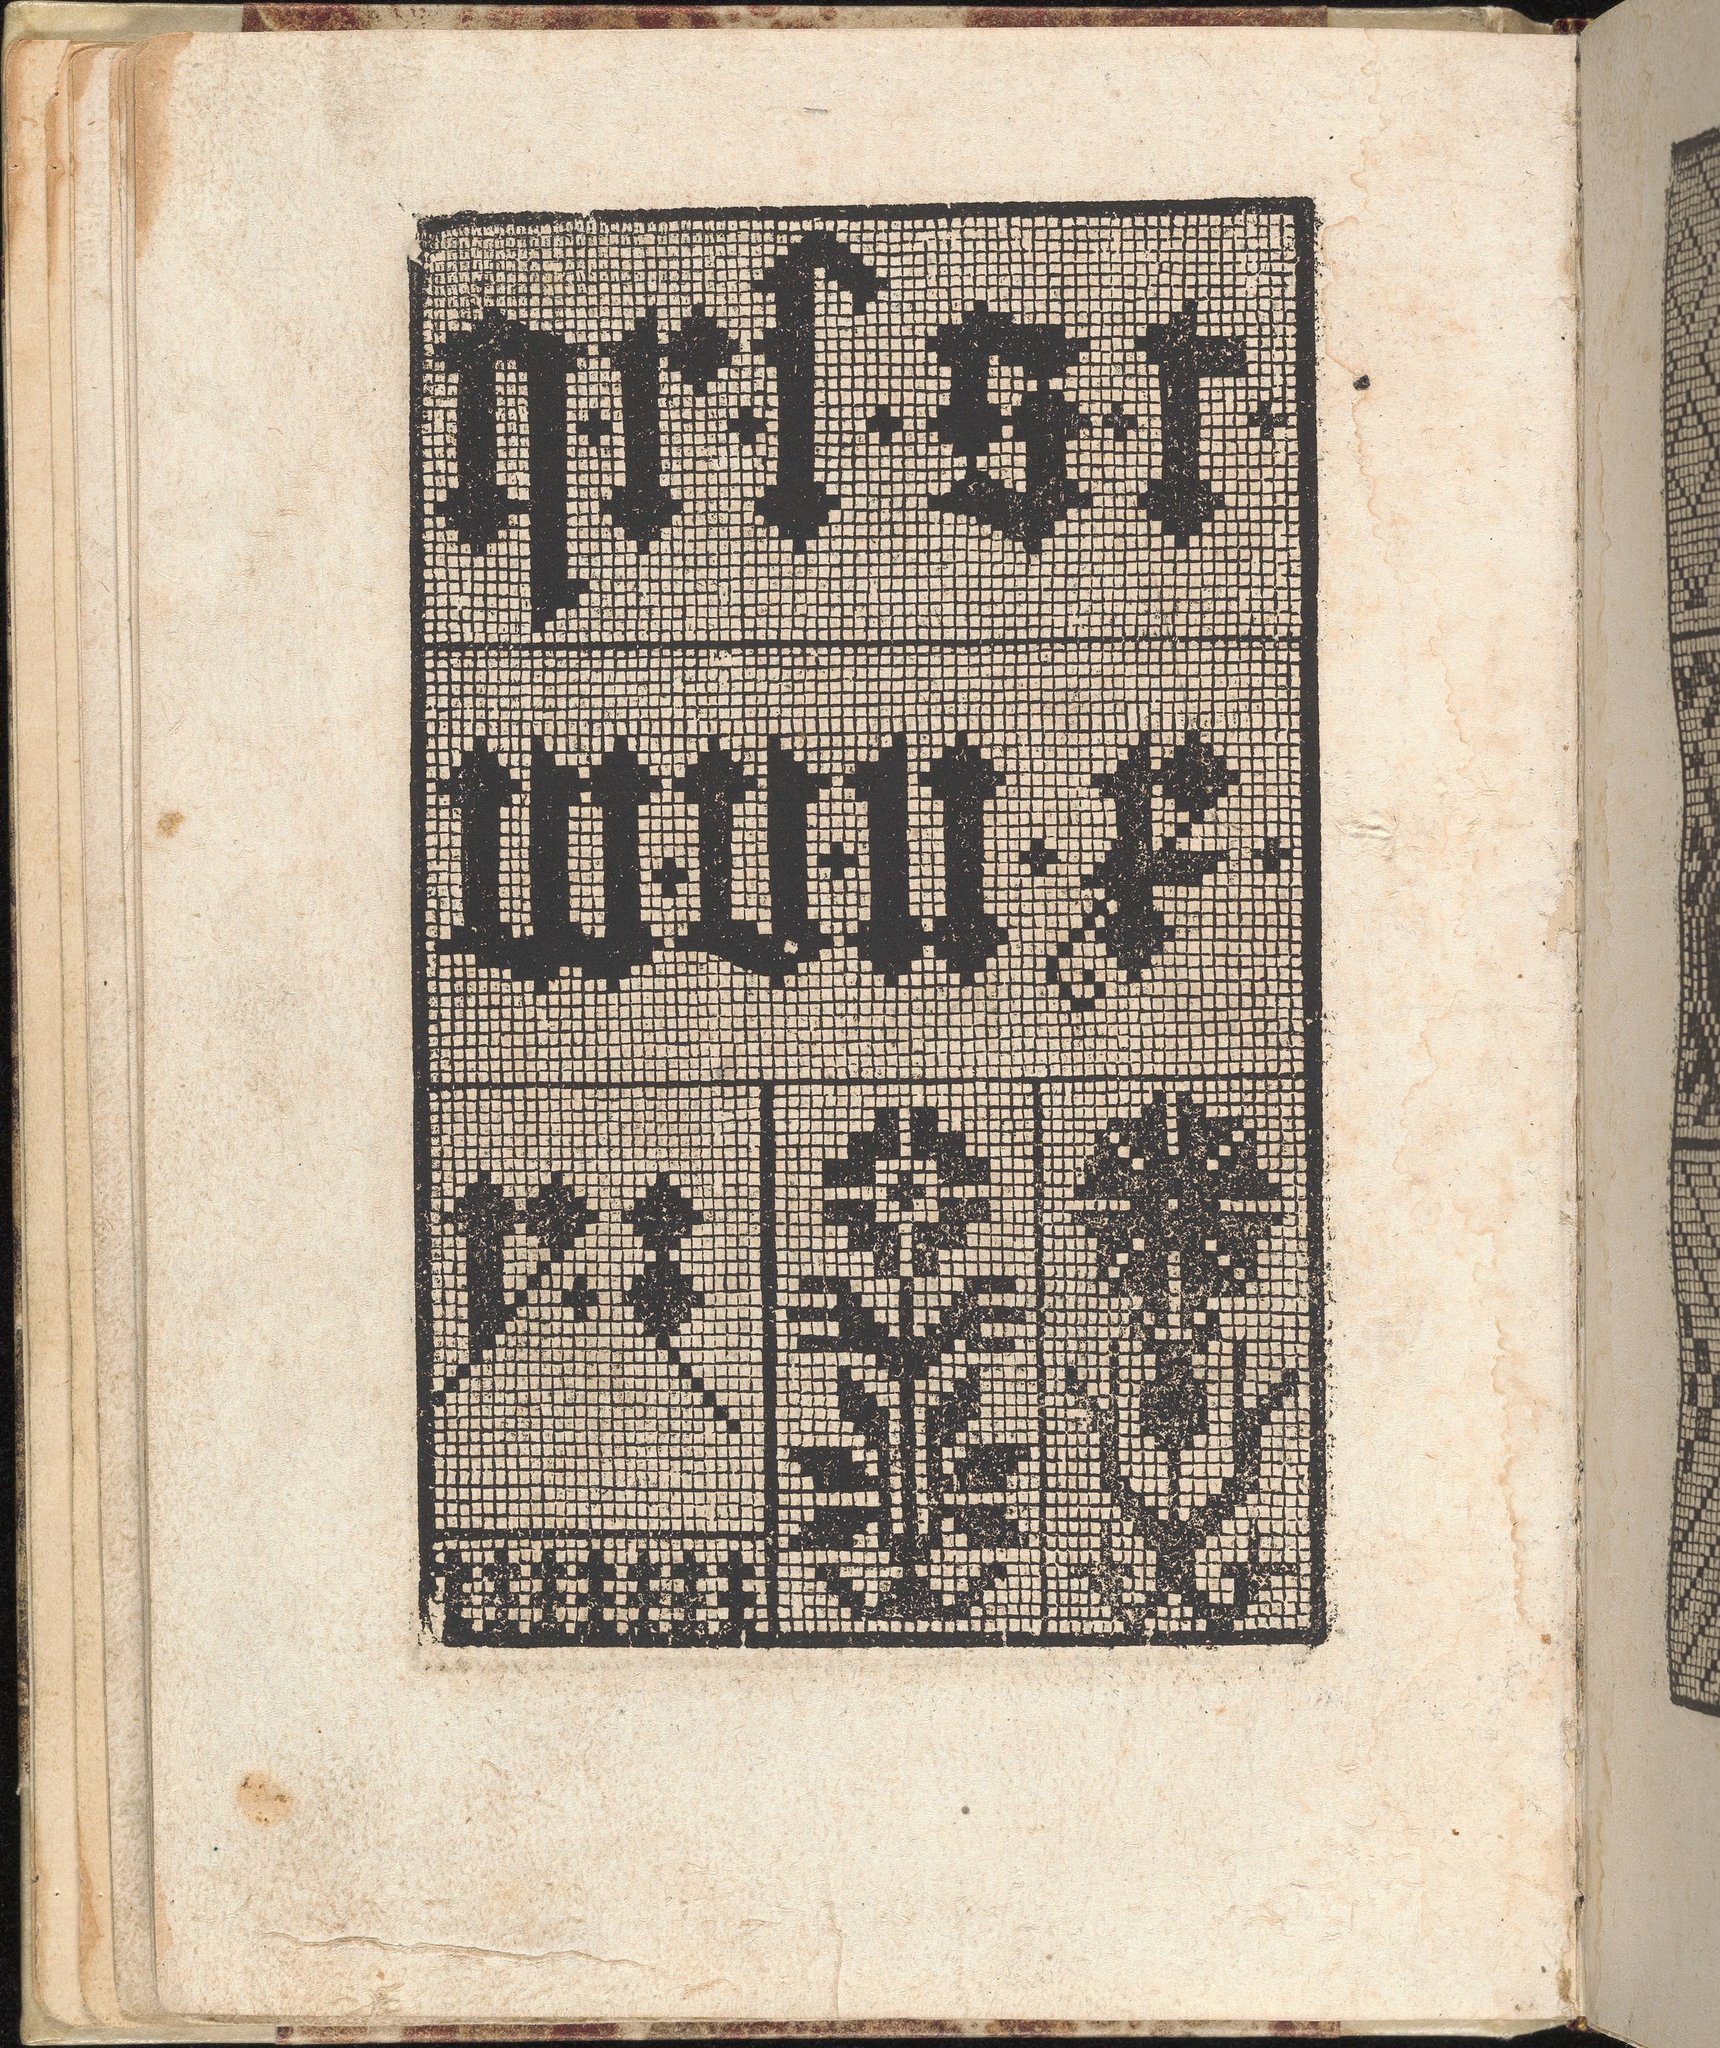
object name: book print ornament architecture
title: Ein new getruckt model Büchli...Page 15, verso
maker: johann schönsperger the younger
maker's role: publisher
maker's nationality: german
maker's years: 1490-1550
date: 1529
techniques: woodcut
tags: ornament